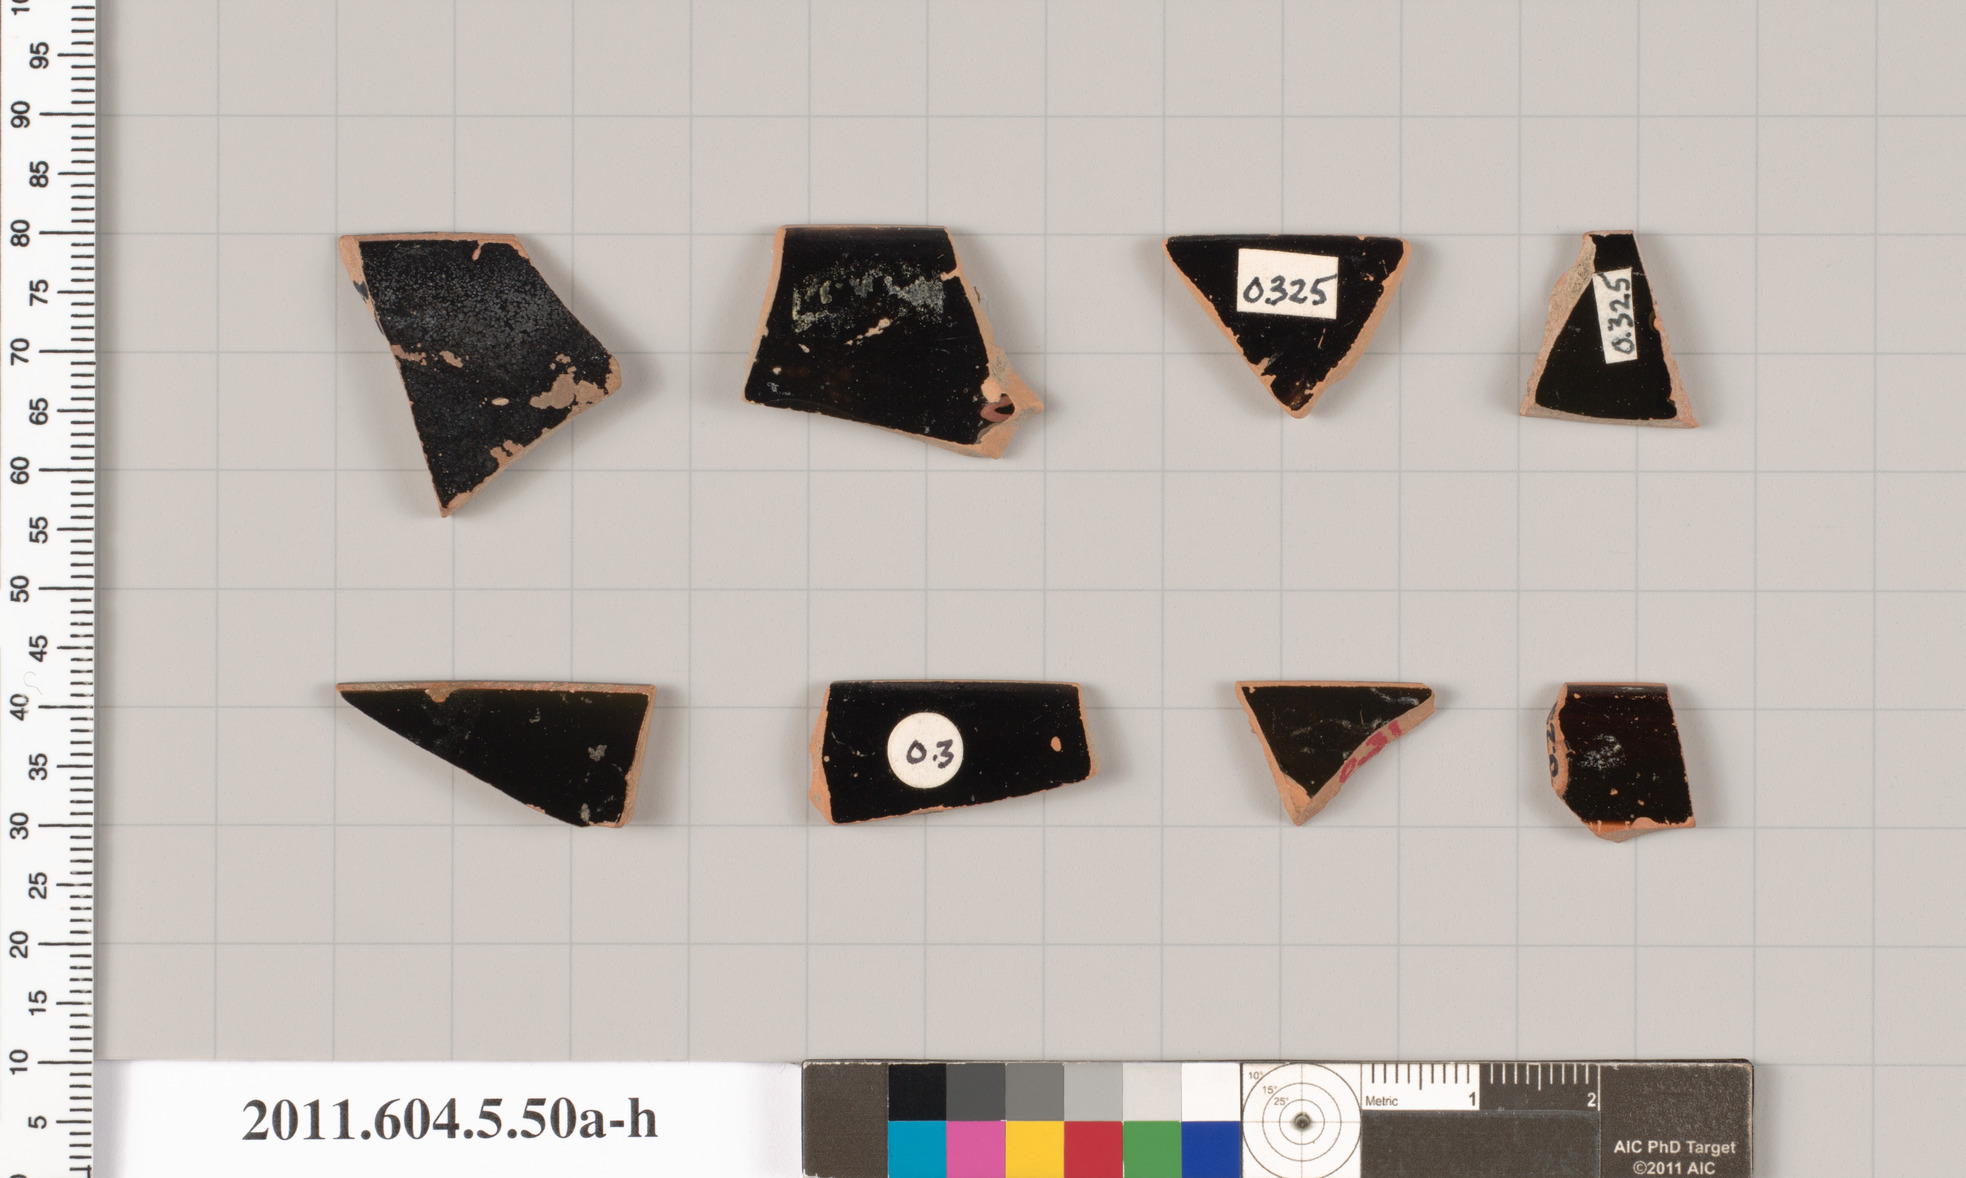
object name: kylix fragment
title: Terracotta rim fragments of kylikes (drinking cups)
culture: greek, attic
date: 500-401 BCE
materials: terracotta